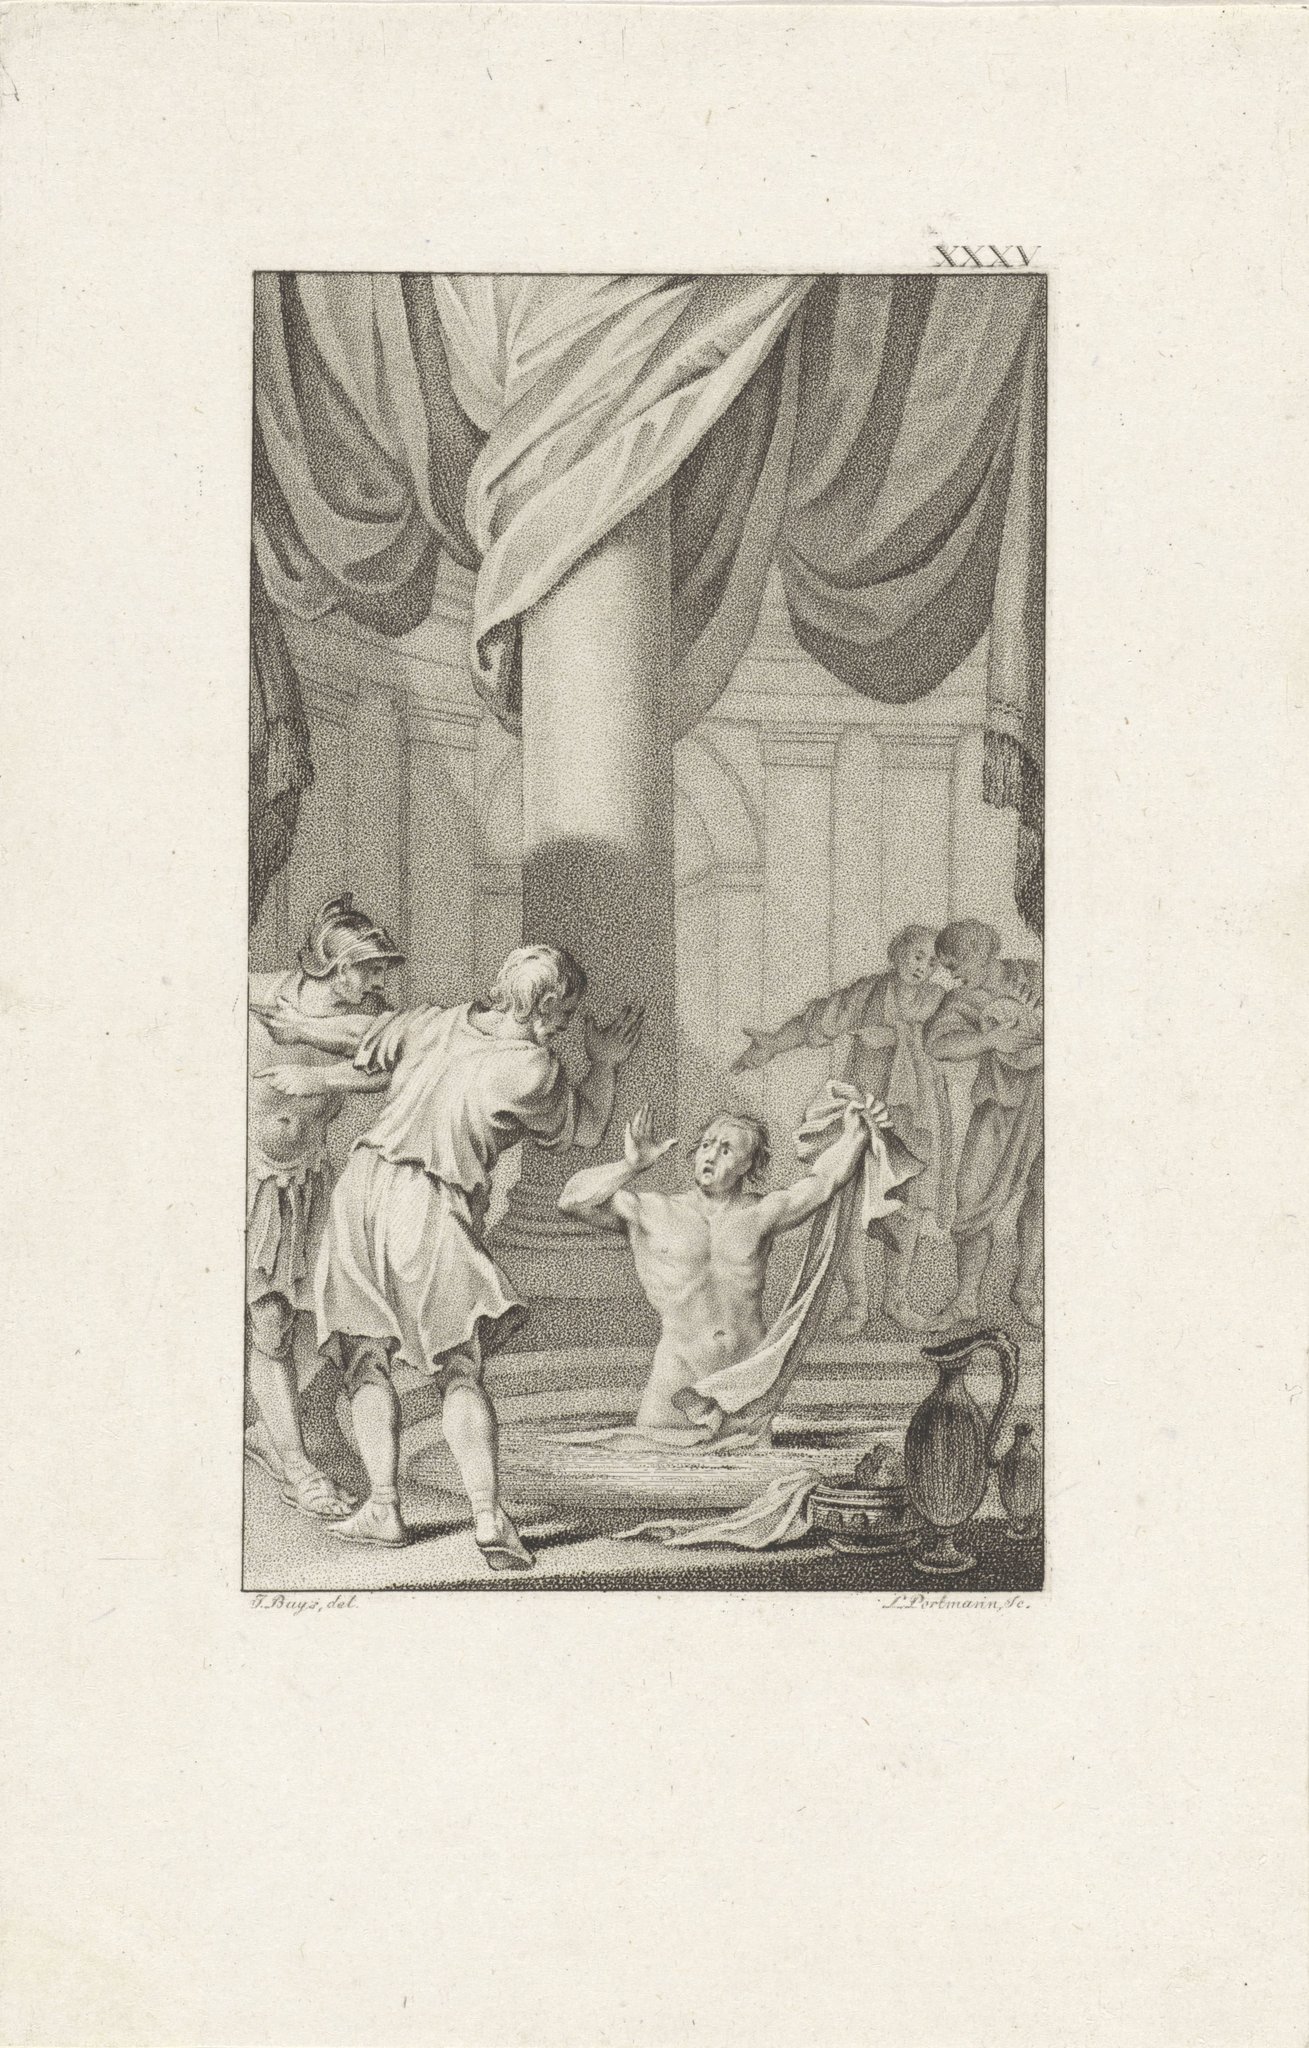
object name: book illustration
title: Overdreven angst van Perseus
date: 1797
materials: paper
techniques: stippled etching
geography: amsterdam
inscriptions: collector's mark: Lugt 2228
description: Perseus zit in de stad Dium in bad. Als hij te horen krijgt dat de vijand onderweg is naar de stad wordt hij onnodig bang. Hij geeft zich zonder gevecht gewonnen en beveelt Hippias en Asclepiodotus alle nederzettingen in Macedonië te ontruimen.